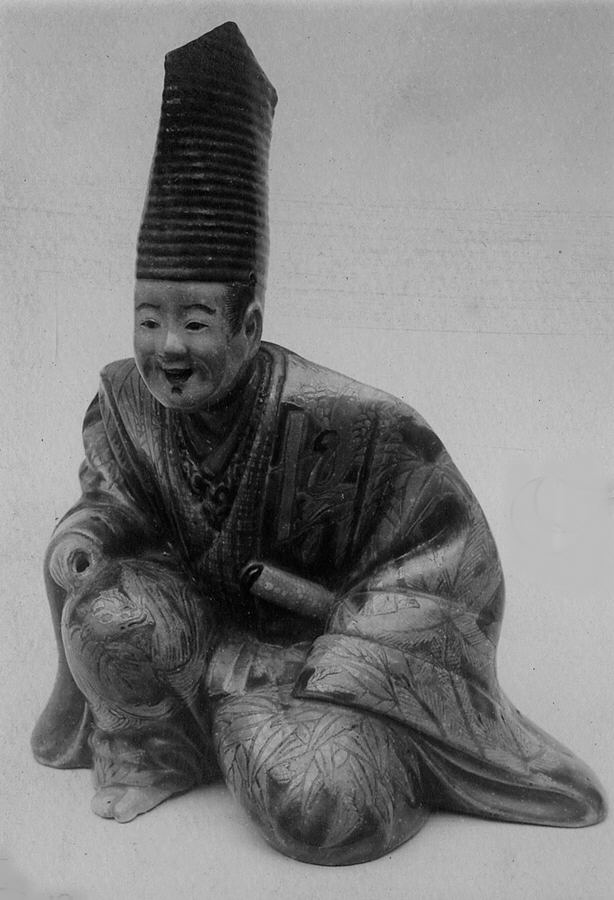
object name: figure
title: Senzai from the Noh Drama Okina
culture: japanese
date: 1780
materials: enamel, gold, stoneware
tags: men